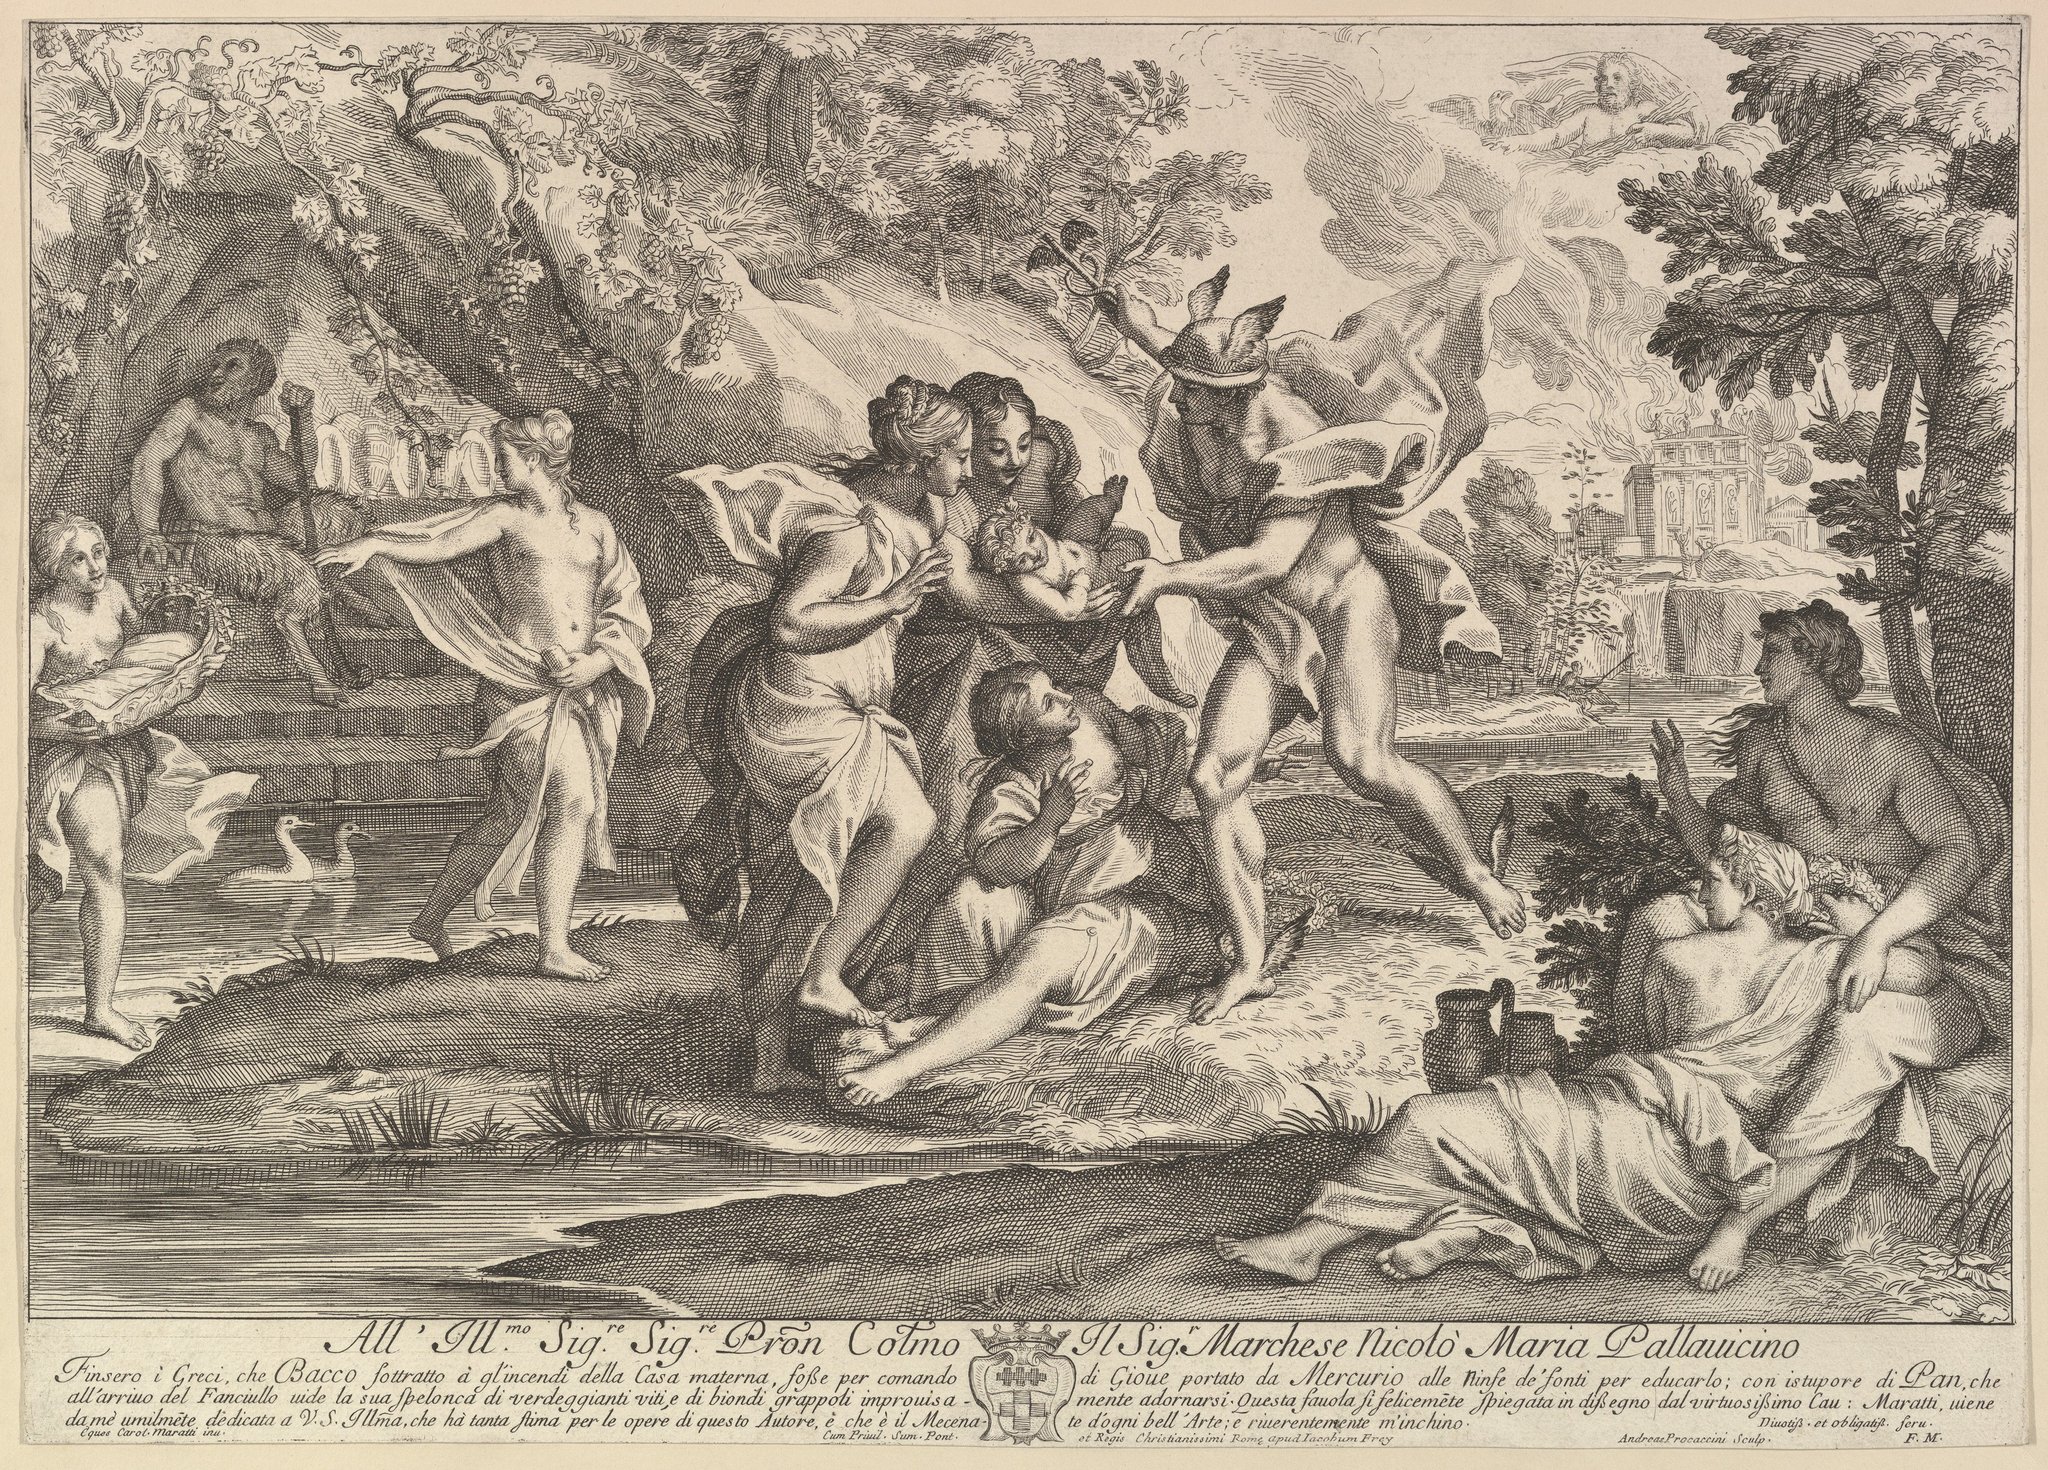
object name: print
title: Bacchus as a child given by Mercury to the care of the Nymphs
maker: andrea procaccini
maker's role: artist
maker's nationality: italian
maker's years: 1671-1734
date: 1671-1734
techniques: engraving, etching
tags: nymphs,bacchus,mercury,swans,trees